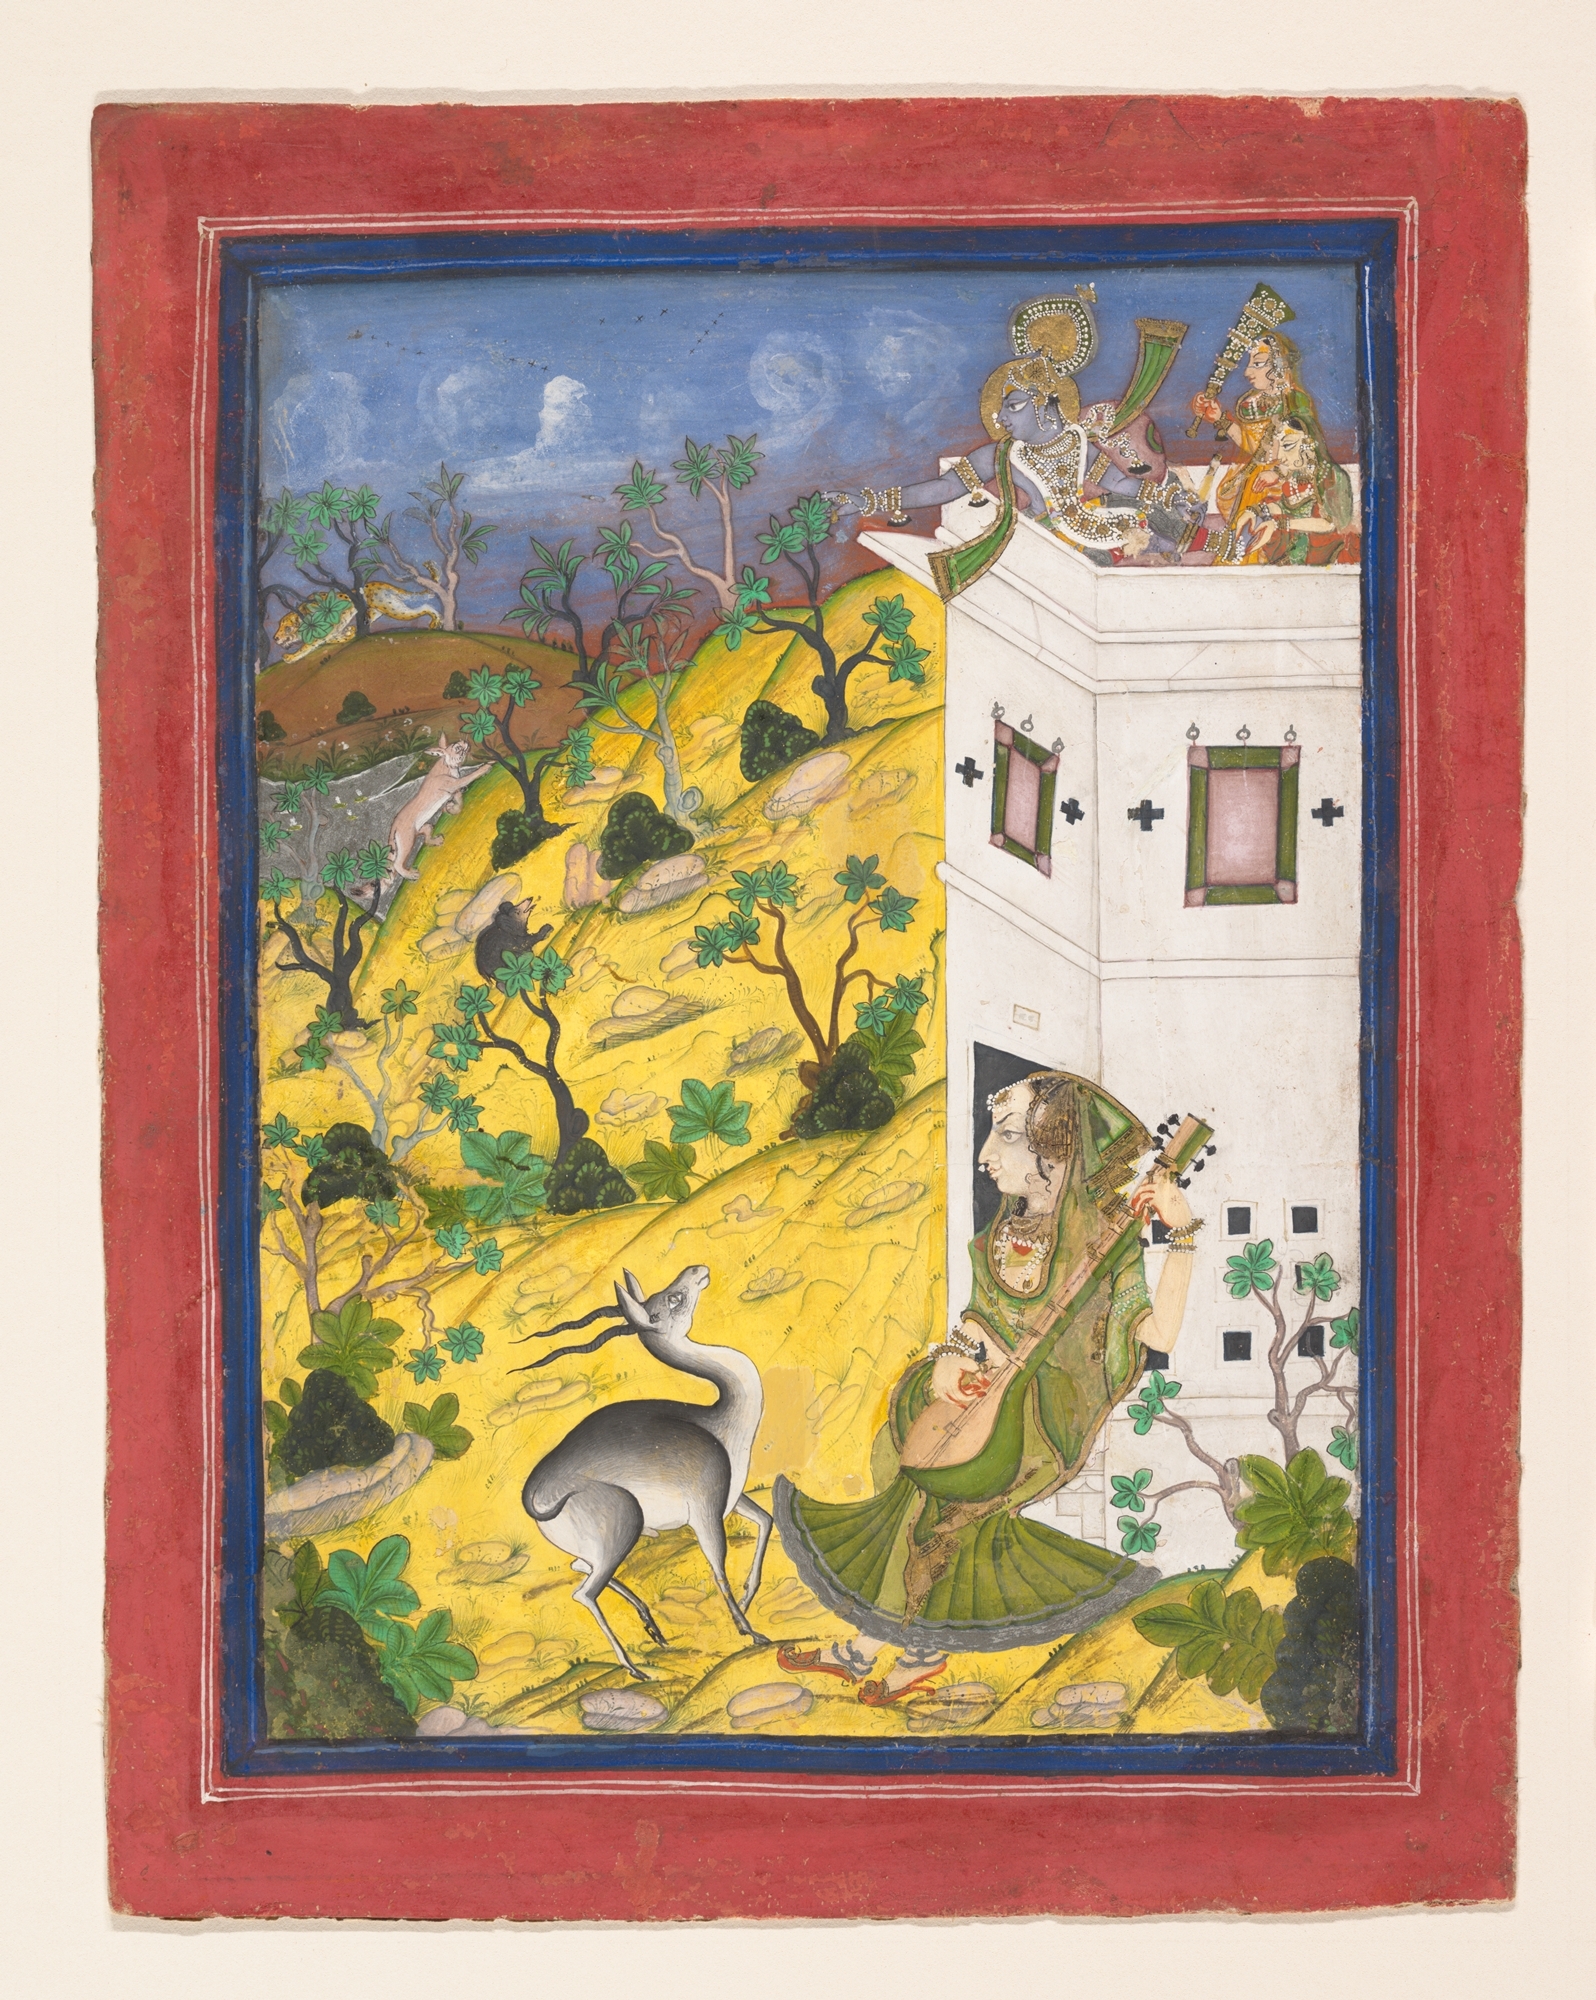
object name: painting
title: A Female Musician Charms an Antelope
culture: indian, rajasthani, kota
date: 1825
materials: textile, ink, watercolor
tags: musical instruments,animals,women,deer,musicians